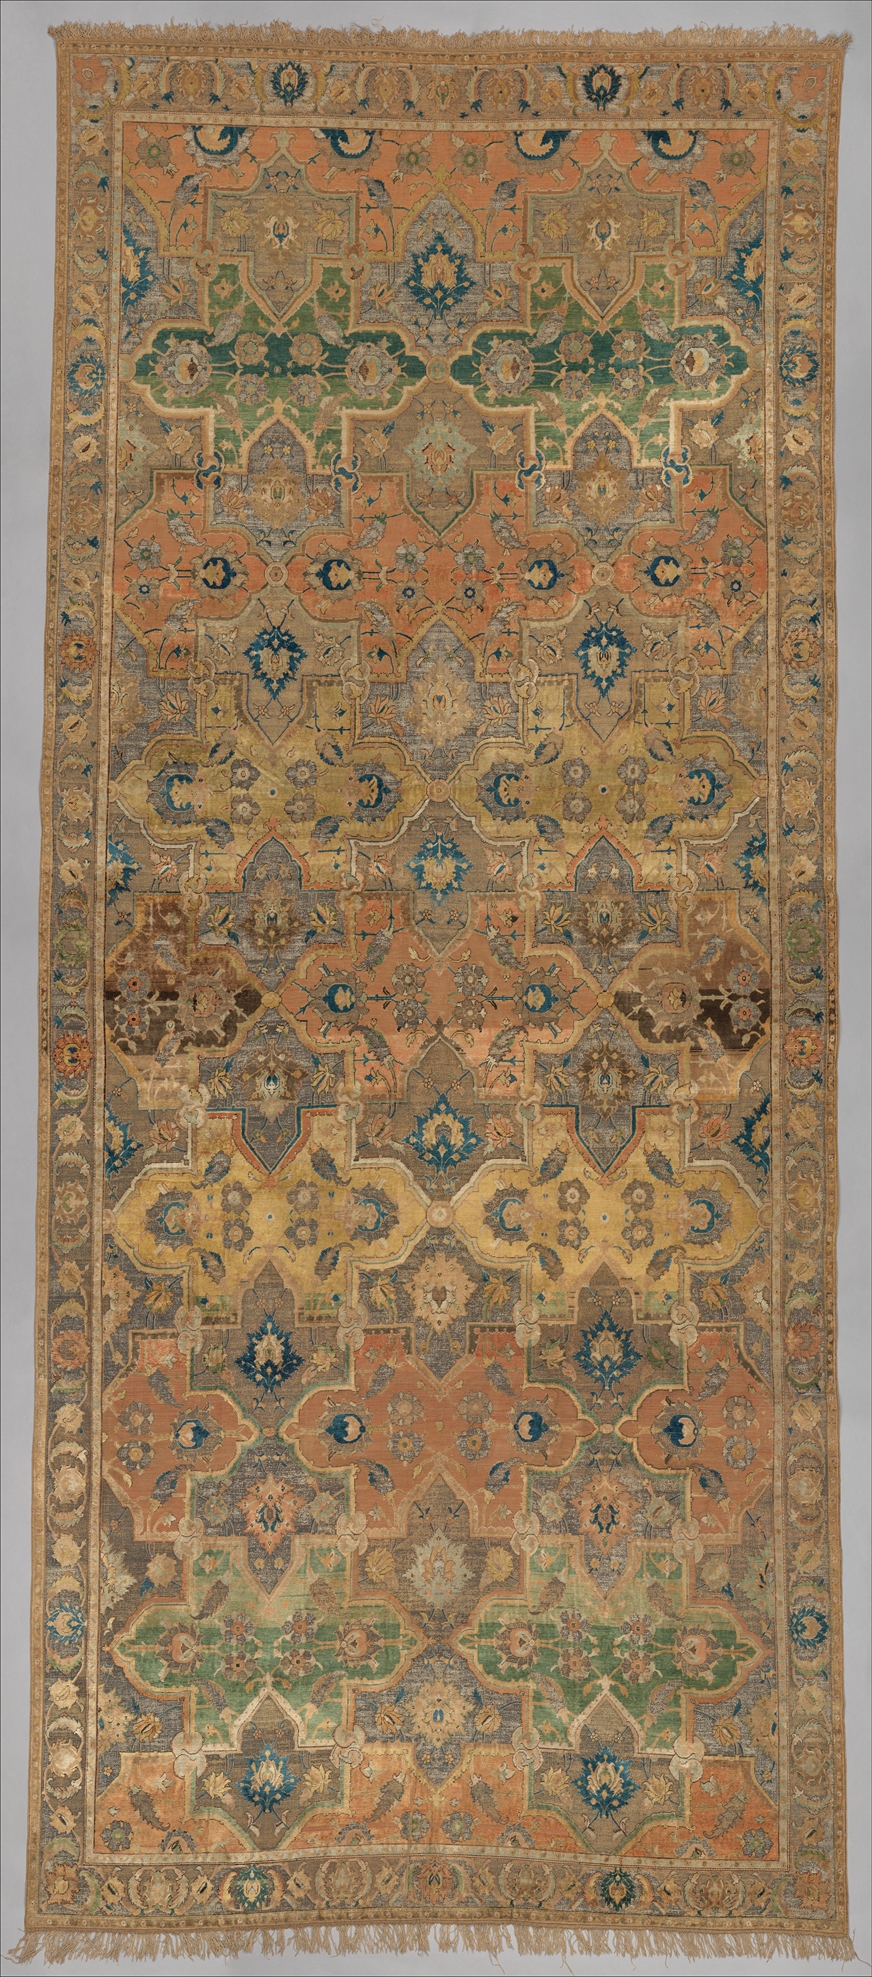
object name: carpet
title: Polonaise Carpet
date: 1601-1700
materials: cotton, metal thread, silk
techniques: asymmetrically knotted pile, brocade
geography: iran